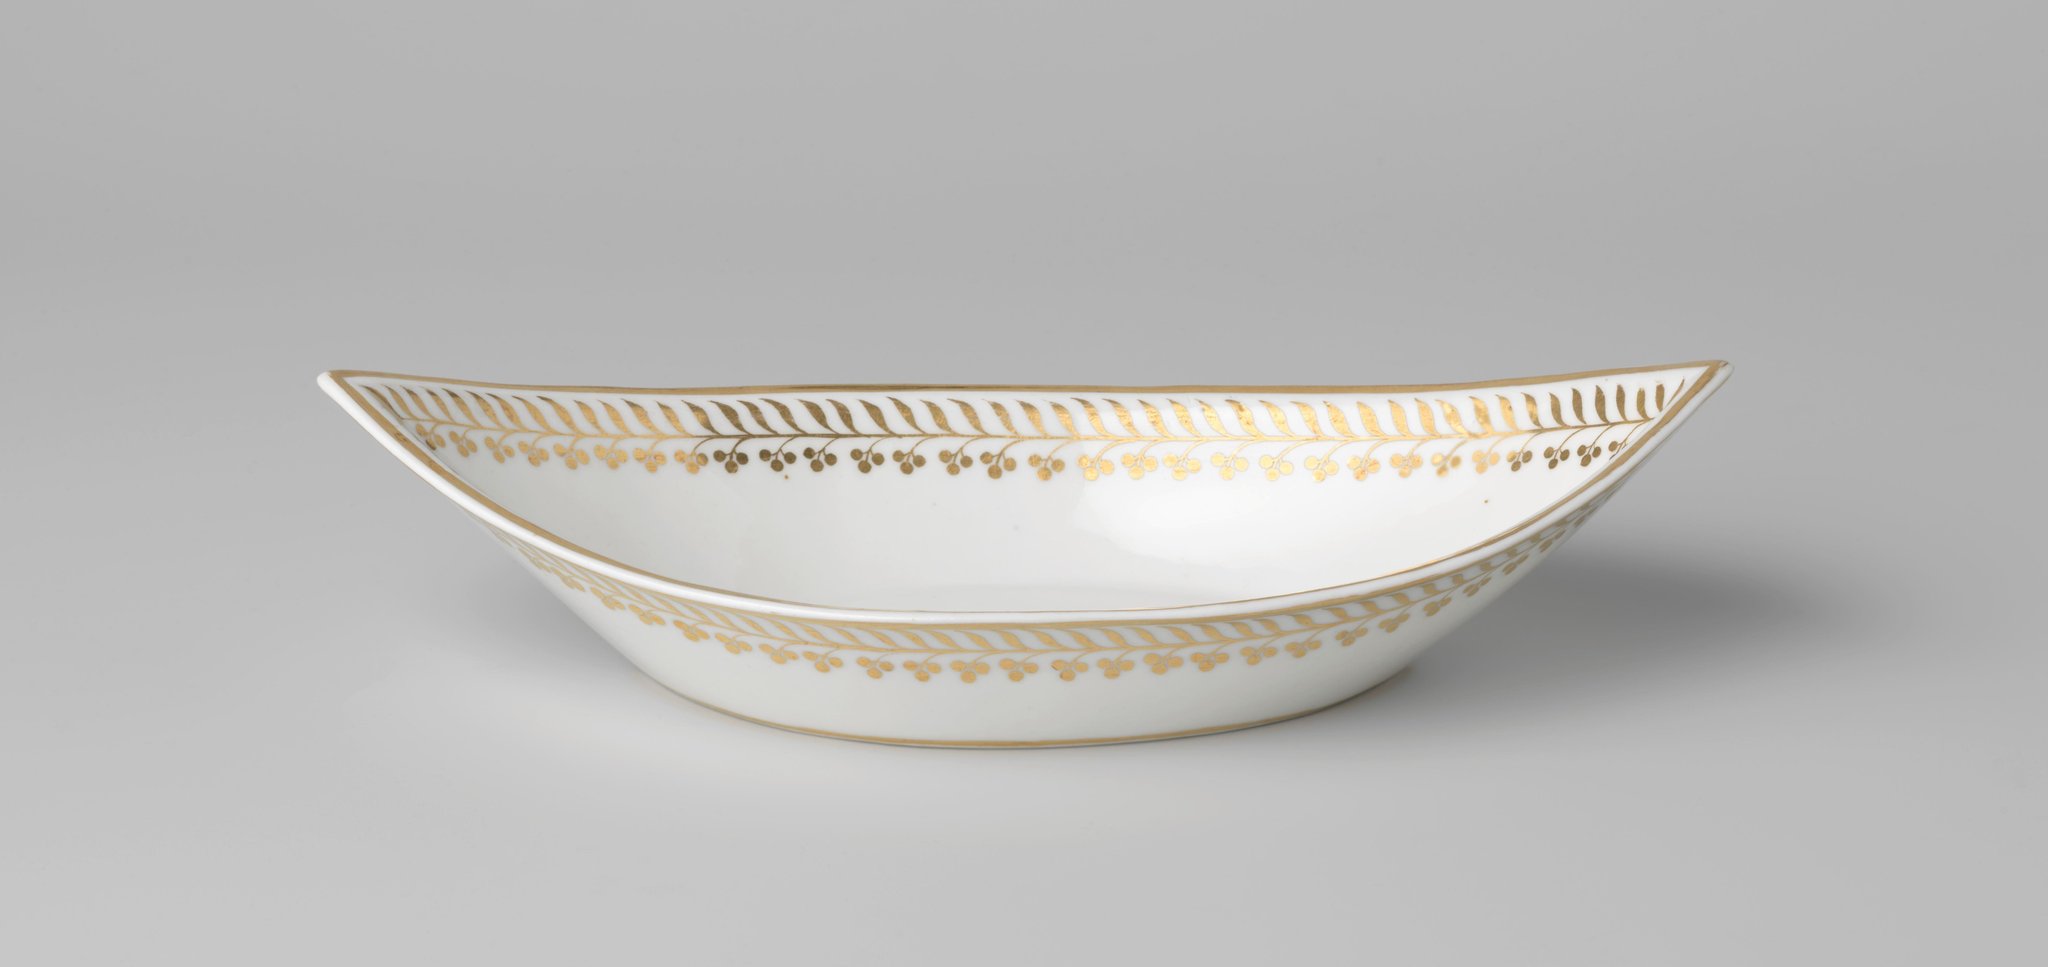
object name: dish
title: Dish with stylized floral scrolls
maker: Anonymous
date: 1800-1810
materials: glaze, gold, paint, porcelain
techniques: firing, forming, gilding, vitrification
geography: france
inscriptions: mark: ‘N?’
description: Ovale schaal van porselein, de korte zijden spits toelopend. Beschilderd op het glazuur in goud. Het plat met een enkele bloemtak. Op de binnenwand een band van gestileerde bloemranken. Gemerkt op de onderzijde met N[?].